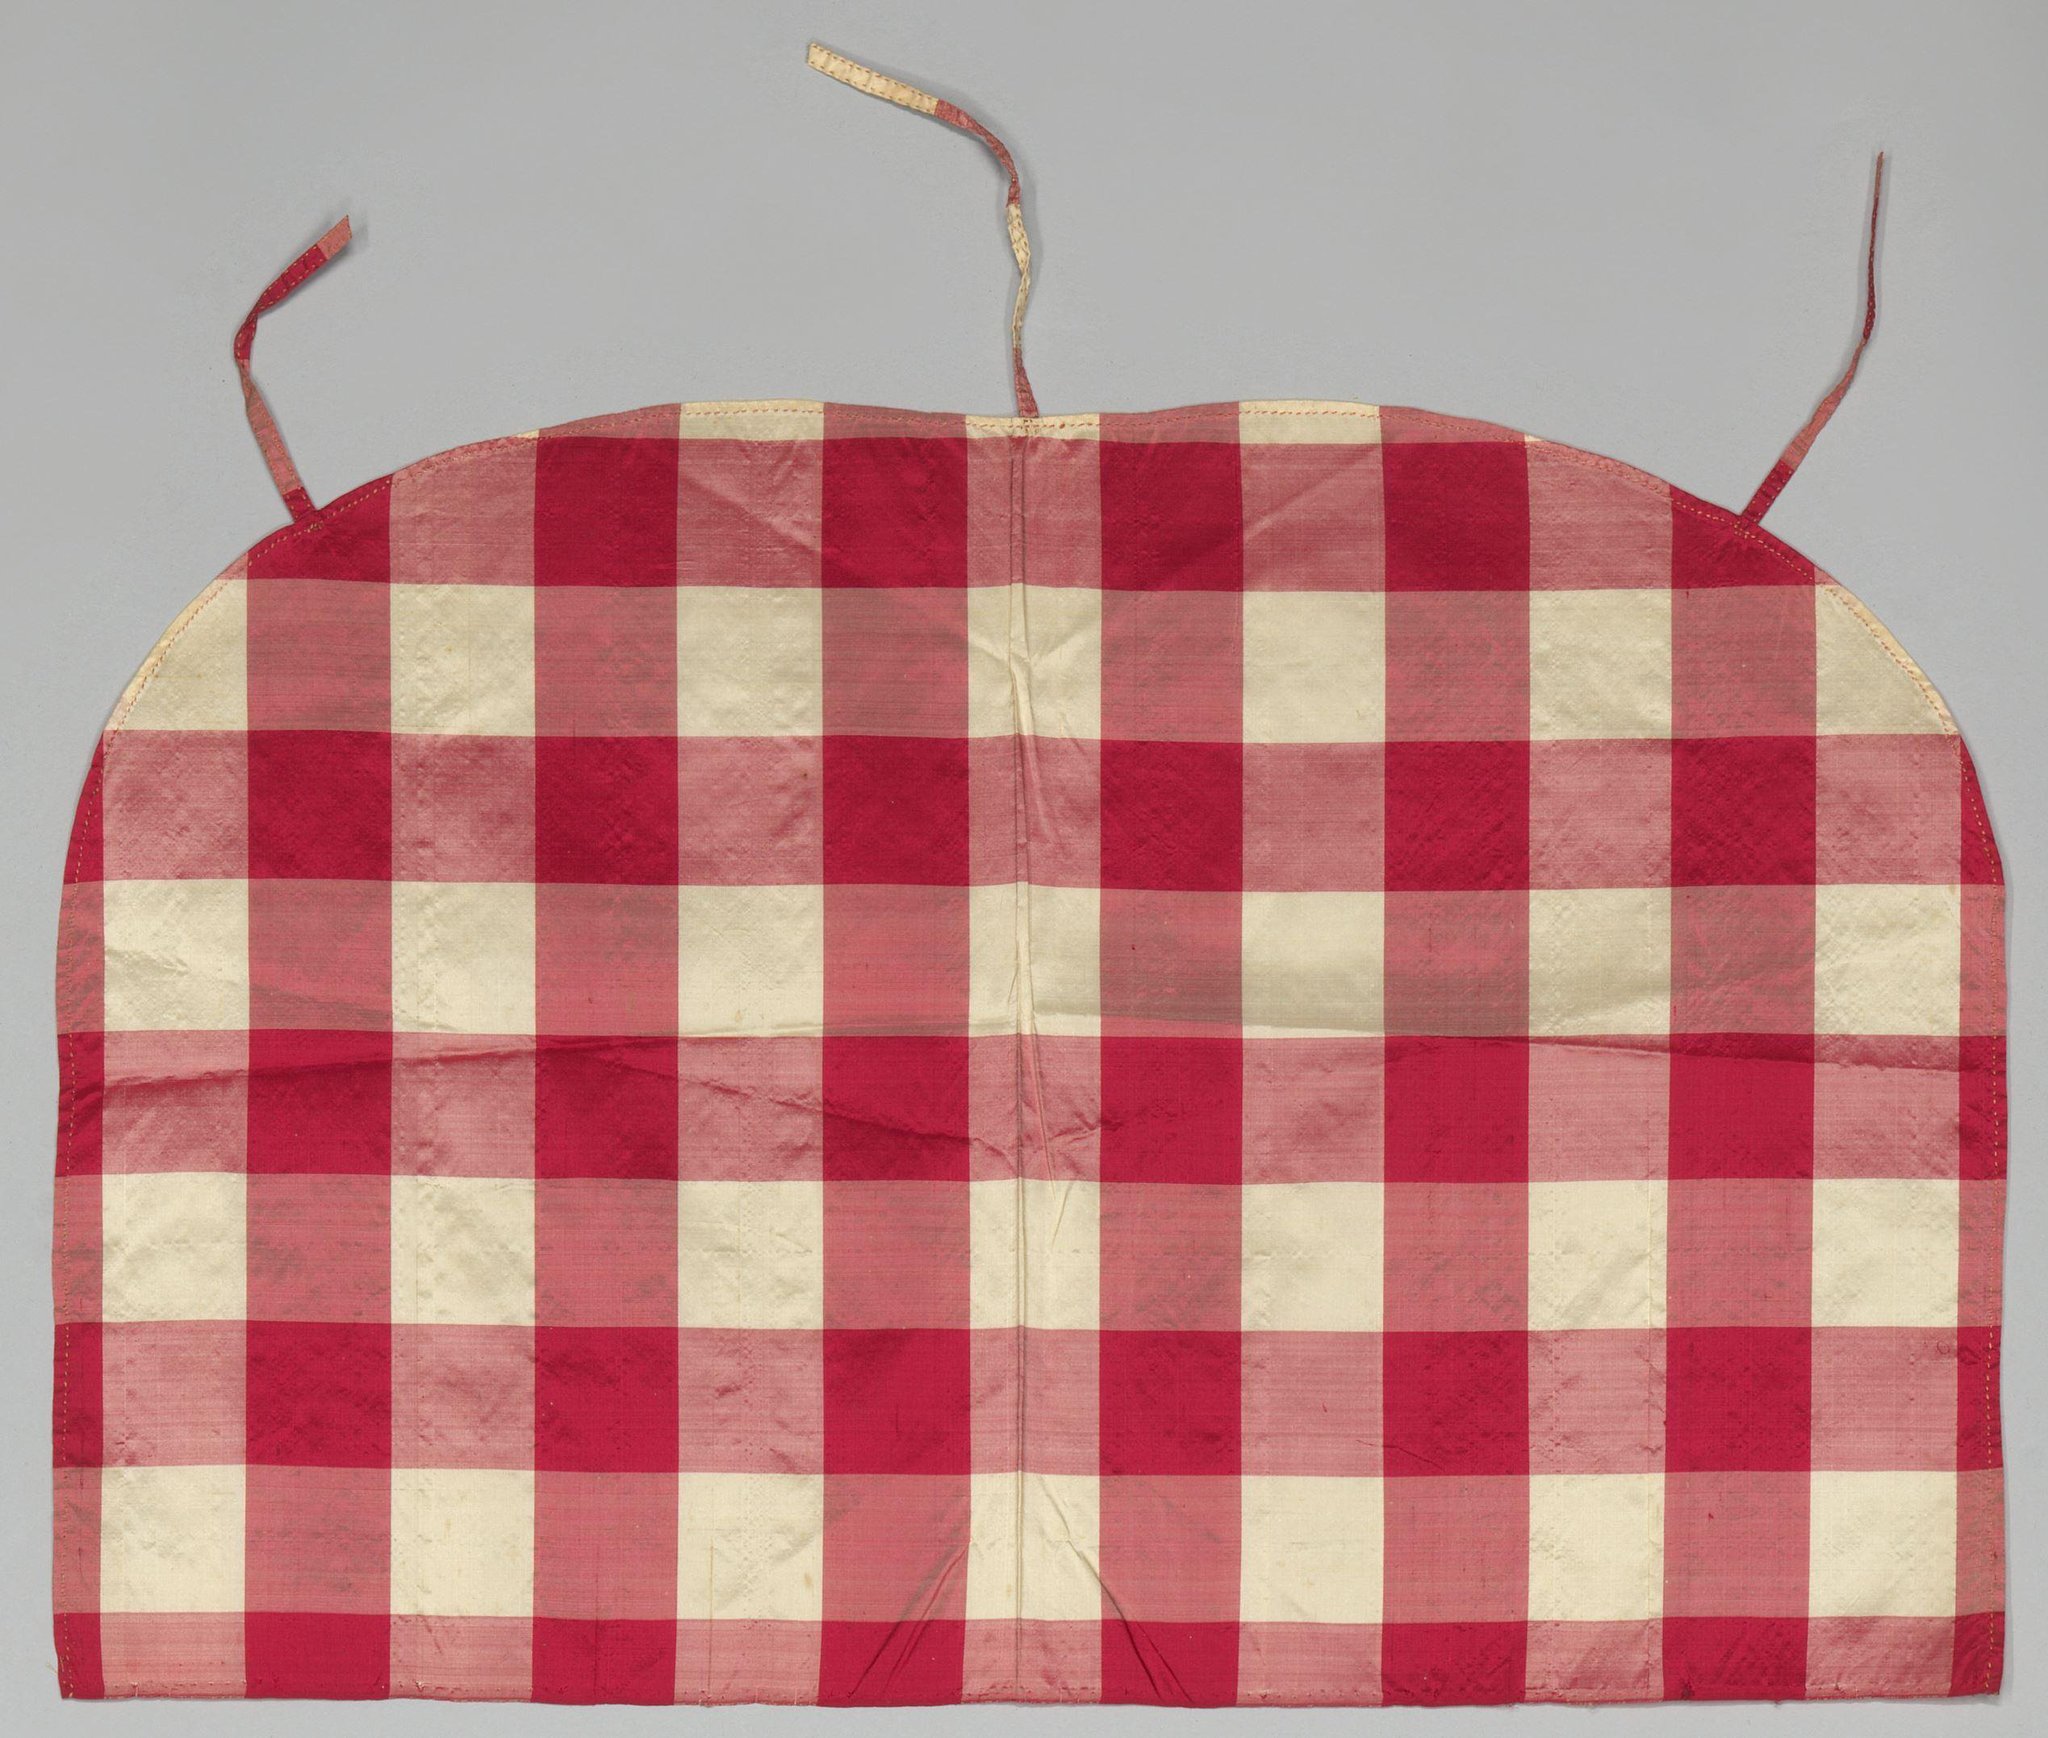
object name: gordijnval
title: Gordijngarnituur, mogelijk een gordijnval, van rood-wit geblokte zijde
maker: Anonymous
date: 1776-1800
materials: silk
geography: northern netherlands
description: Schildvormig gordijngarnituur, mogelijk een gordijnval, met drie bandjes van dezelfde stof van ca. 10.0 cm.